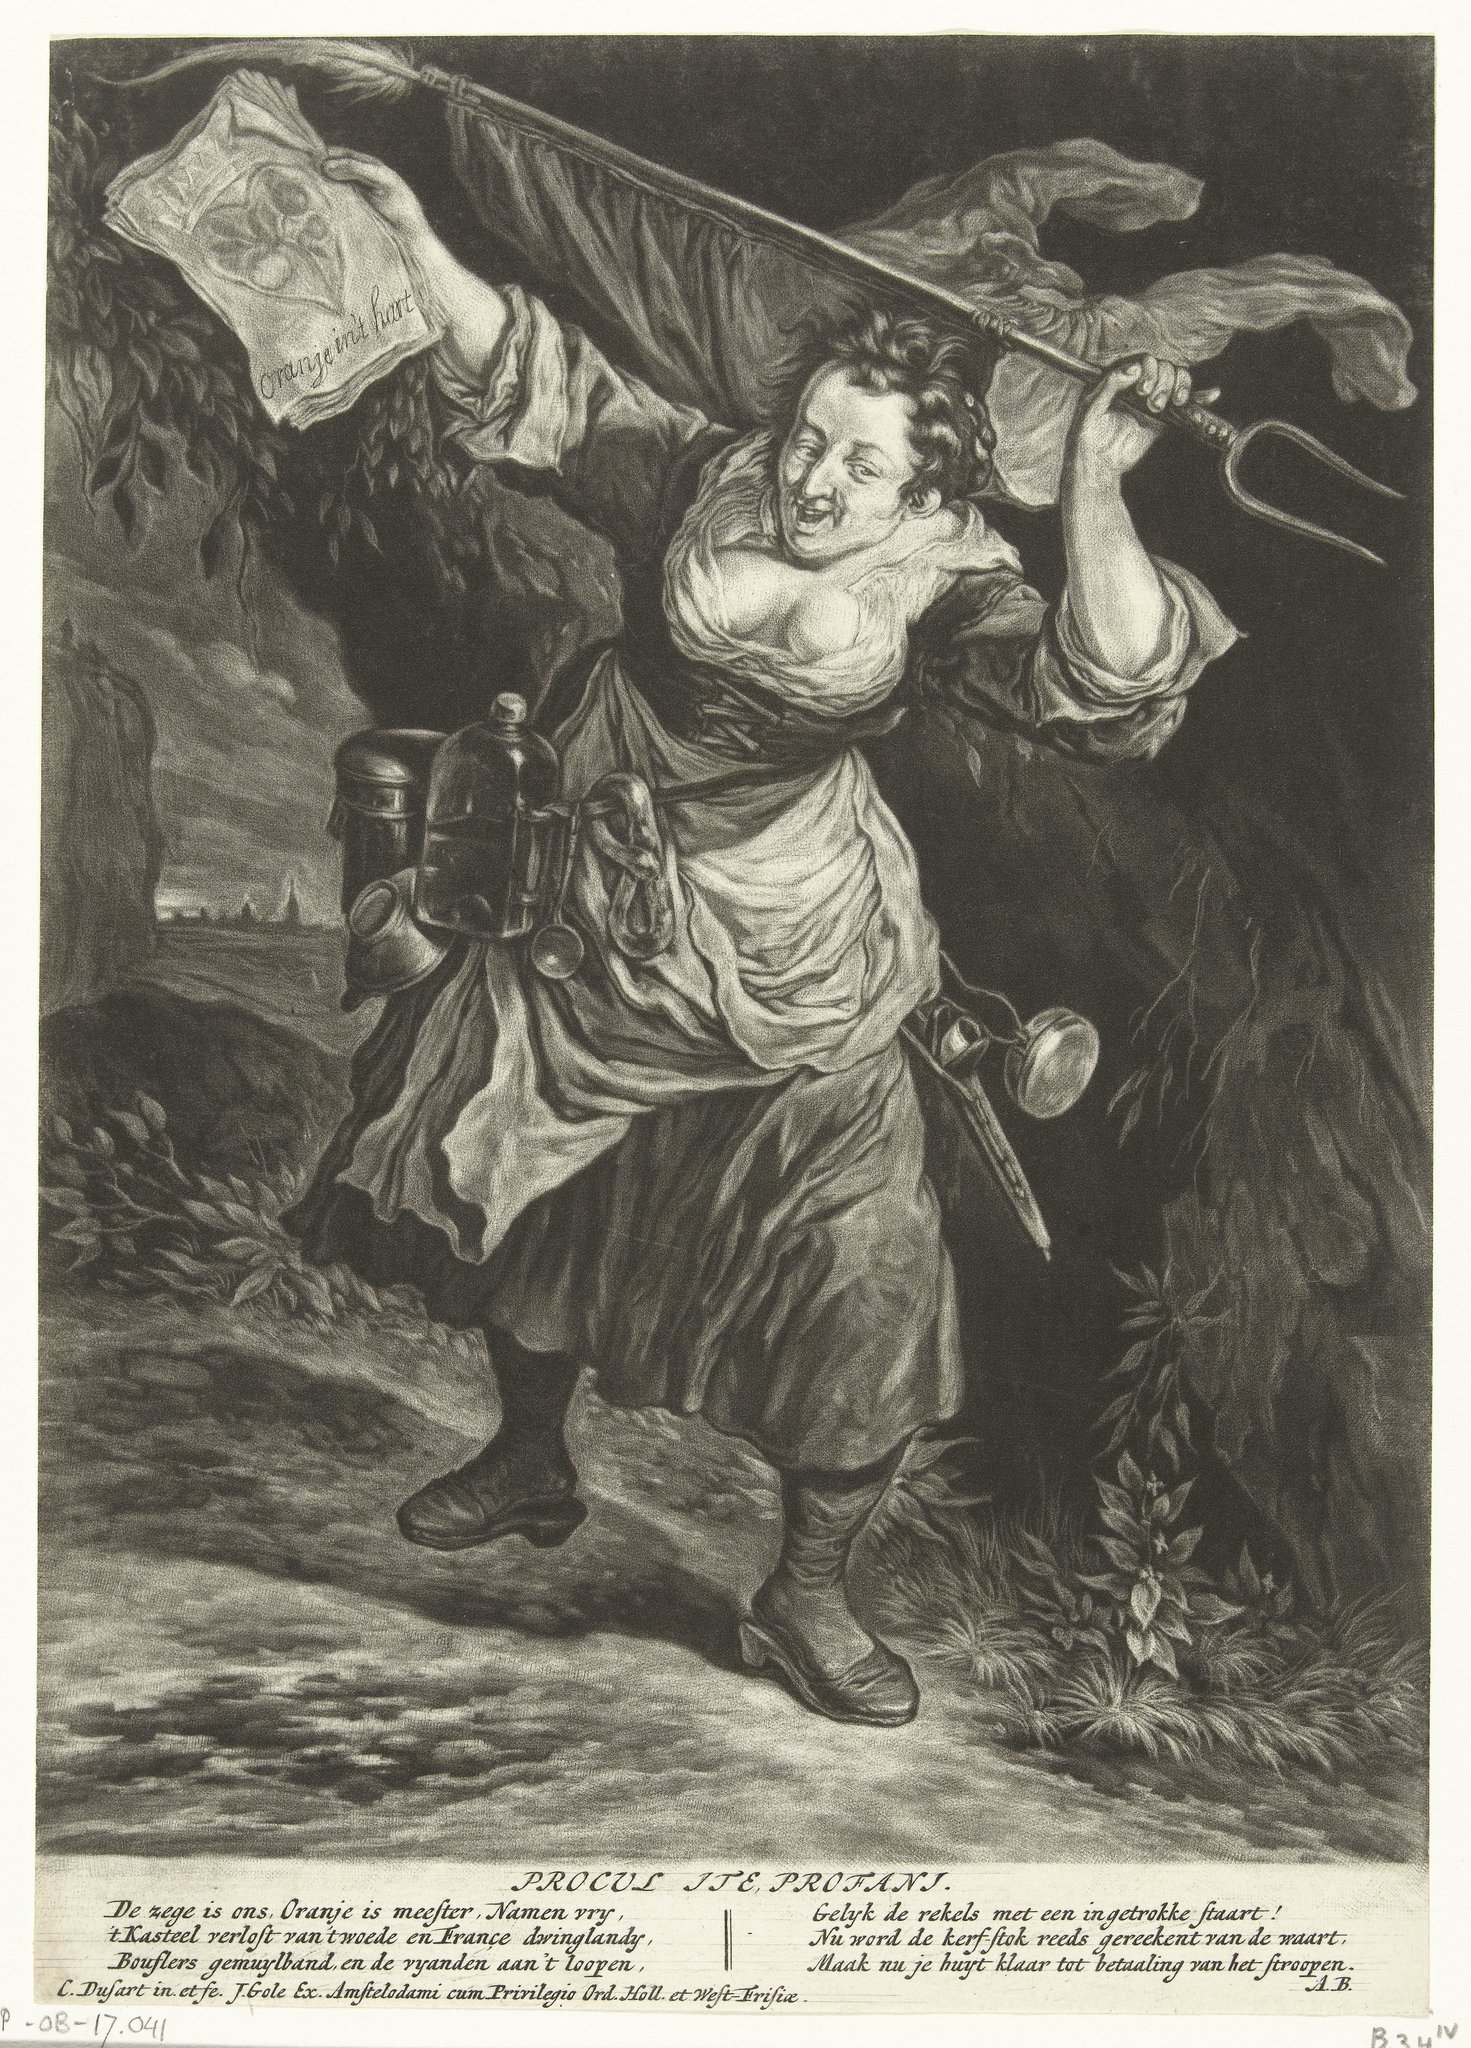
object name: print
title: De Orangiste, 1695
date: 1695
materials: paper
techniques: mezzotint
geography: amsterdam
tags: the hague, william iii (prince of orange and king of england, scotland, and ireland), festivities on events of national importance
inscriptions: collector's mark: Lugt 2228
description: De Orangiste. Dansende vrouw met in de hand een orangistisch pamflet. Onder de voorstelling een Latijnse titel en een Nederlands vers van zes regels. De prent is onderdeel van een reeks van acht prenten vervaardigd naar aanleiding van de verovering van Namen door de geallieerden op 5 september 1695.